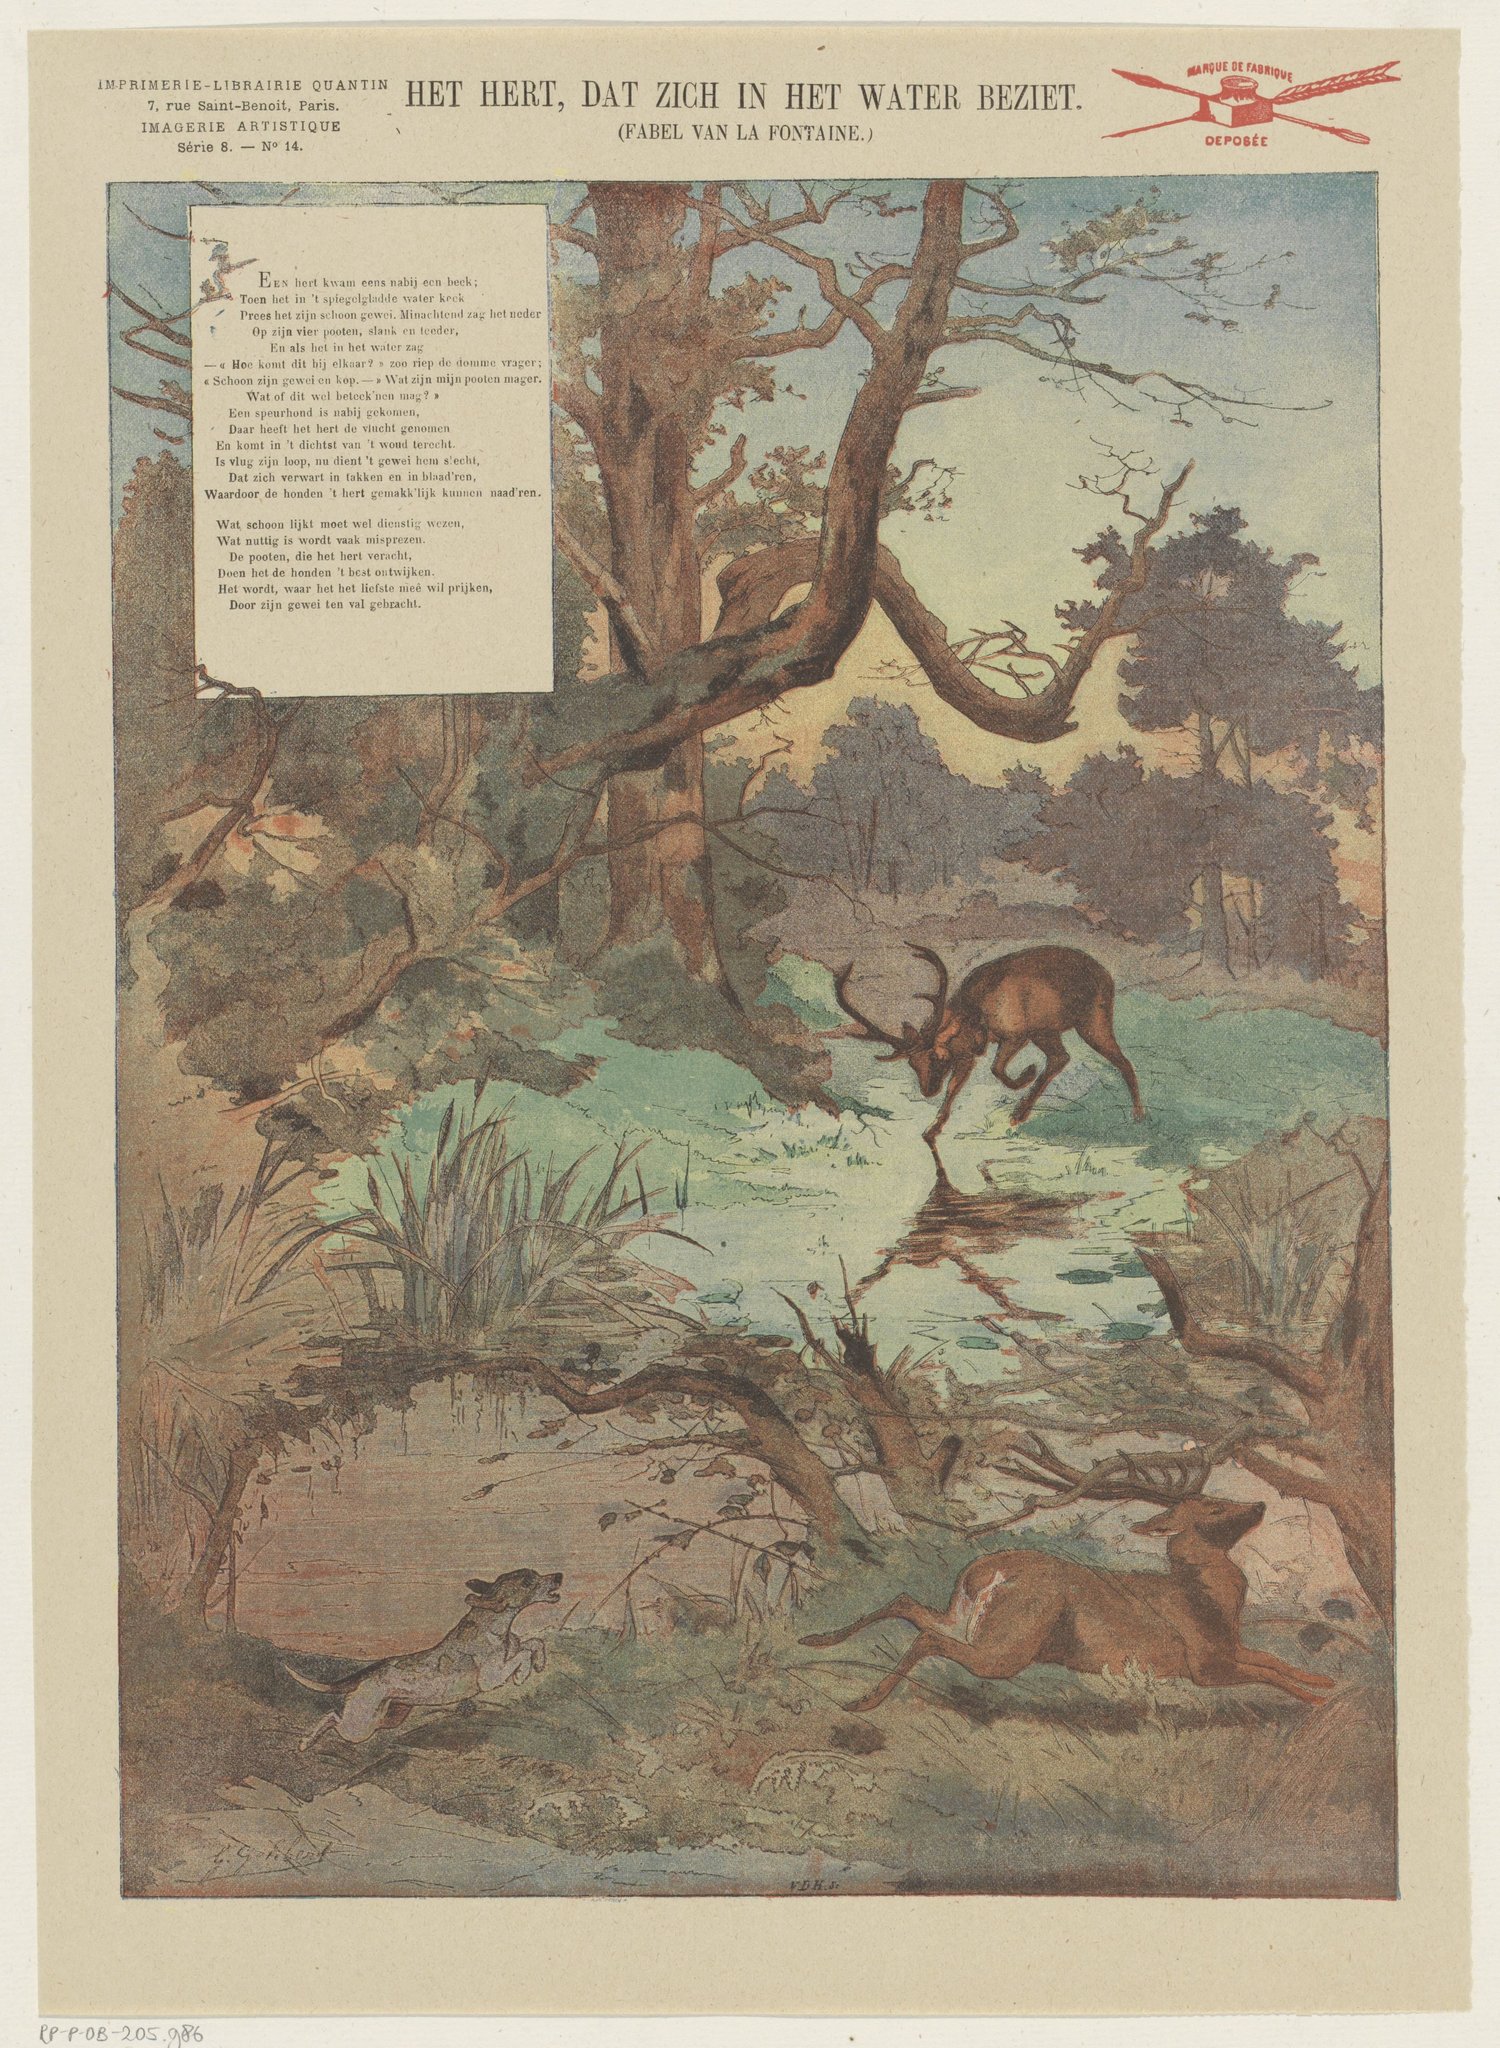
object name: popular print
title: Imagerie Artistique / Série 8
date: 1876-1890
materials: paper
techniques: lithograph, letterpress printing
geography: paris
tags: hoofed animals: deer, fables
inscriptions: collector's mark: Lugt 2760, : ‘marque de fabrique / deposée’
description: Blad met een grote voorstelling uit de fabel van Jean de La Fontaine, van het hert dat zich in het water beziet. Linksboven een tekstblok met een vers. Genummerd linksboven: Série 8. - No. 14.